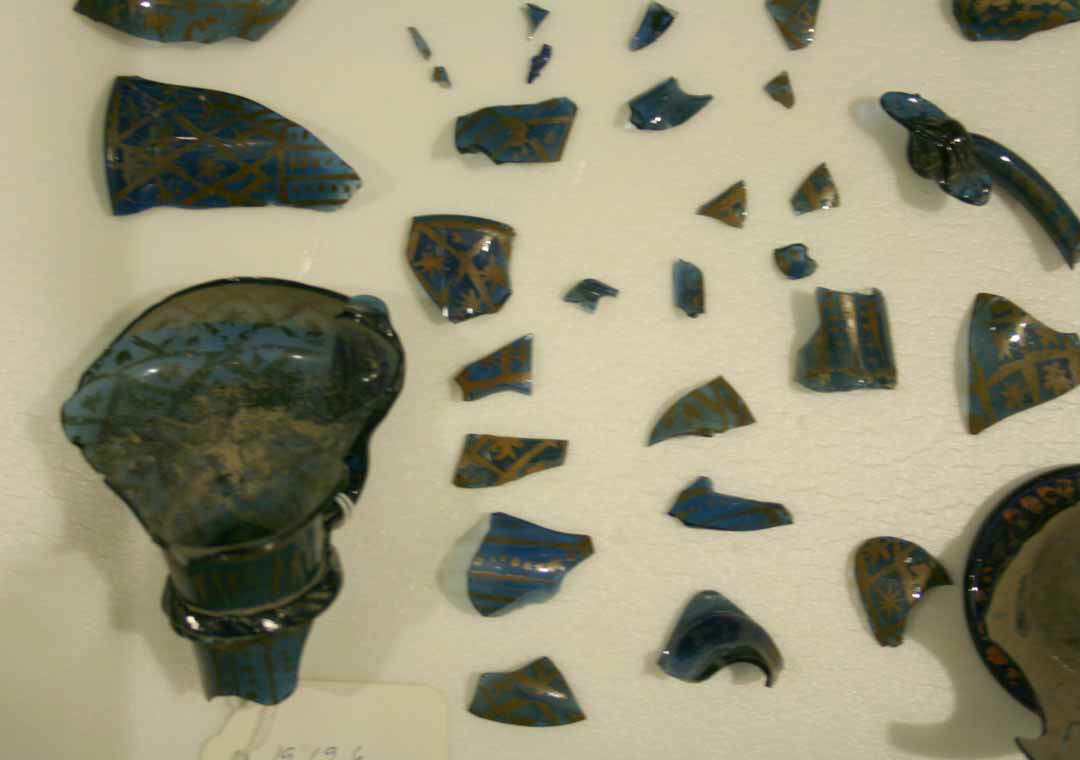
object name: ewer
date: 1701-1900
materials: glass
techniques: painting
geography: iran